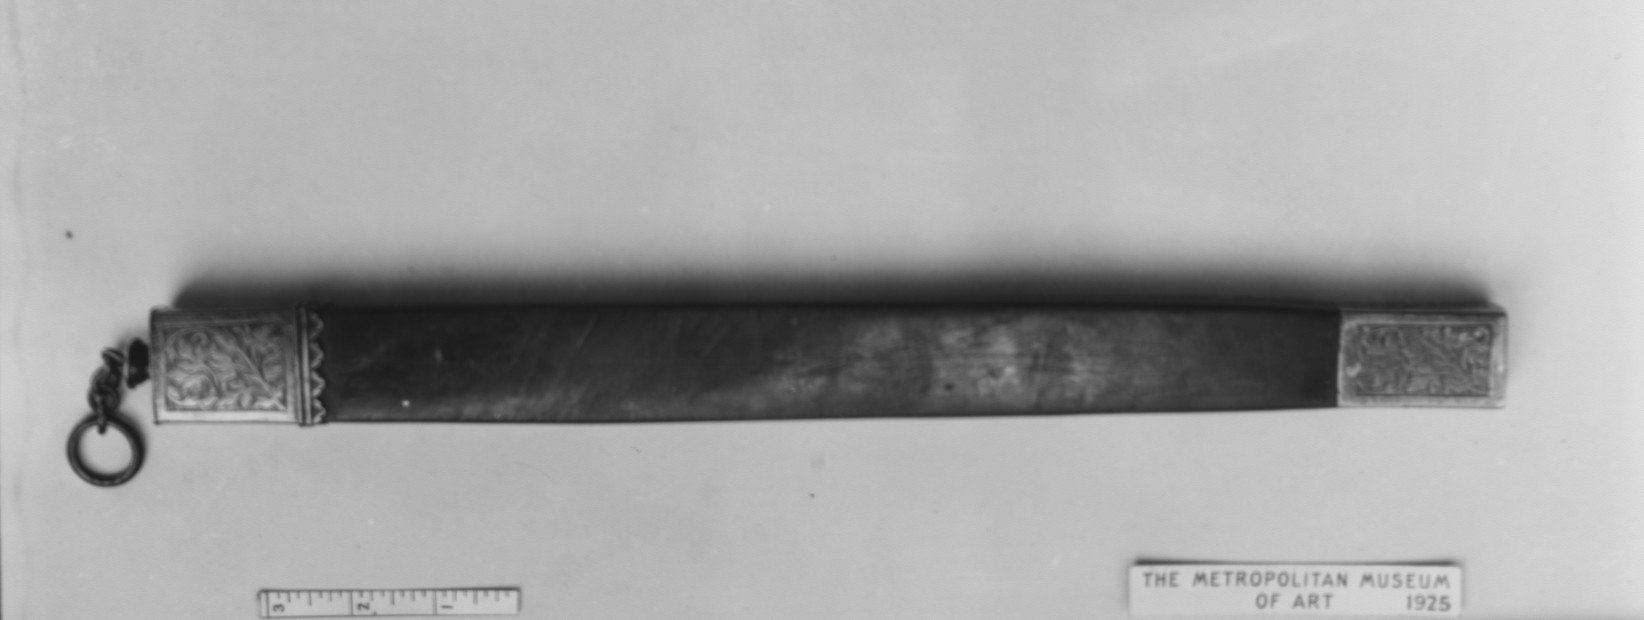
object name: whetstone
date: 1574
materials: brass, stone